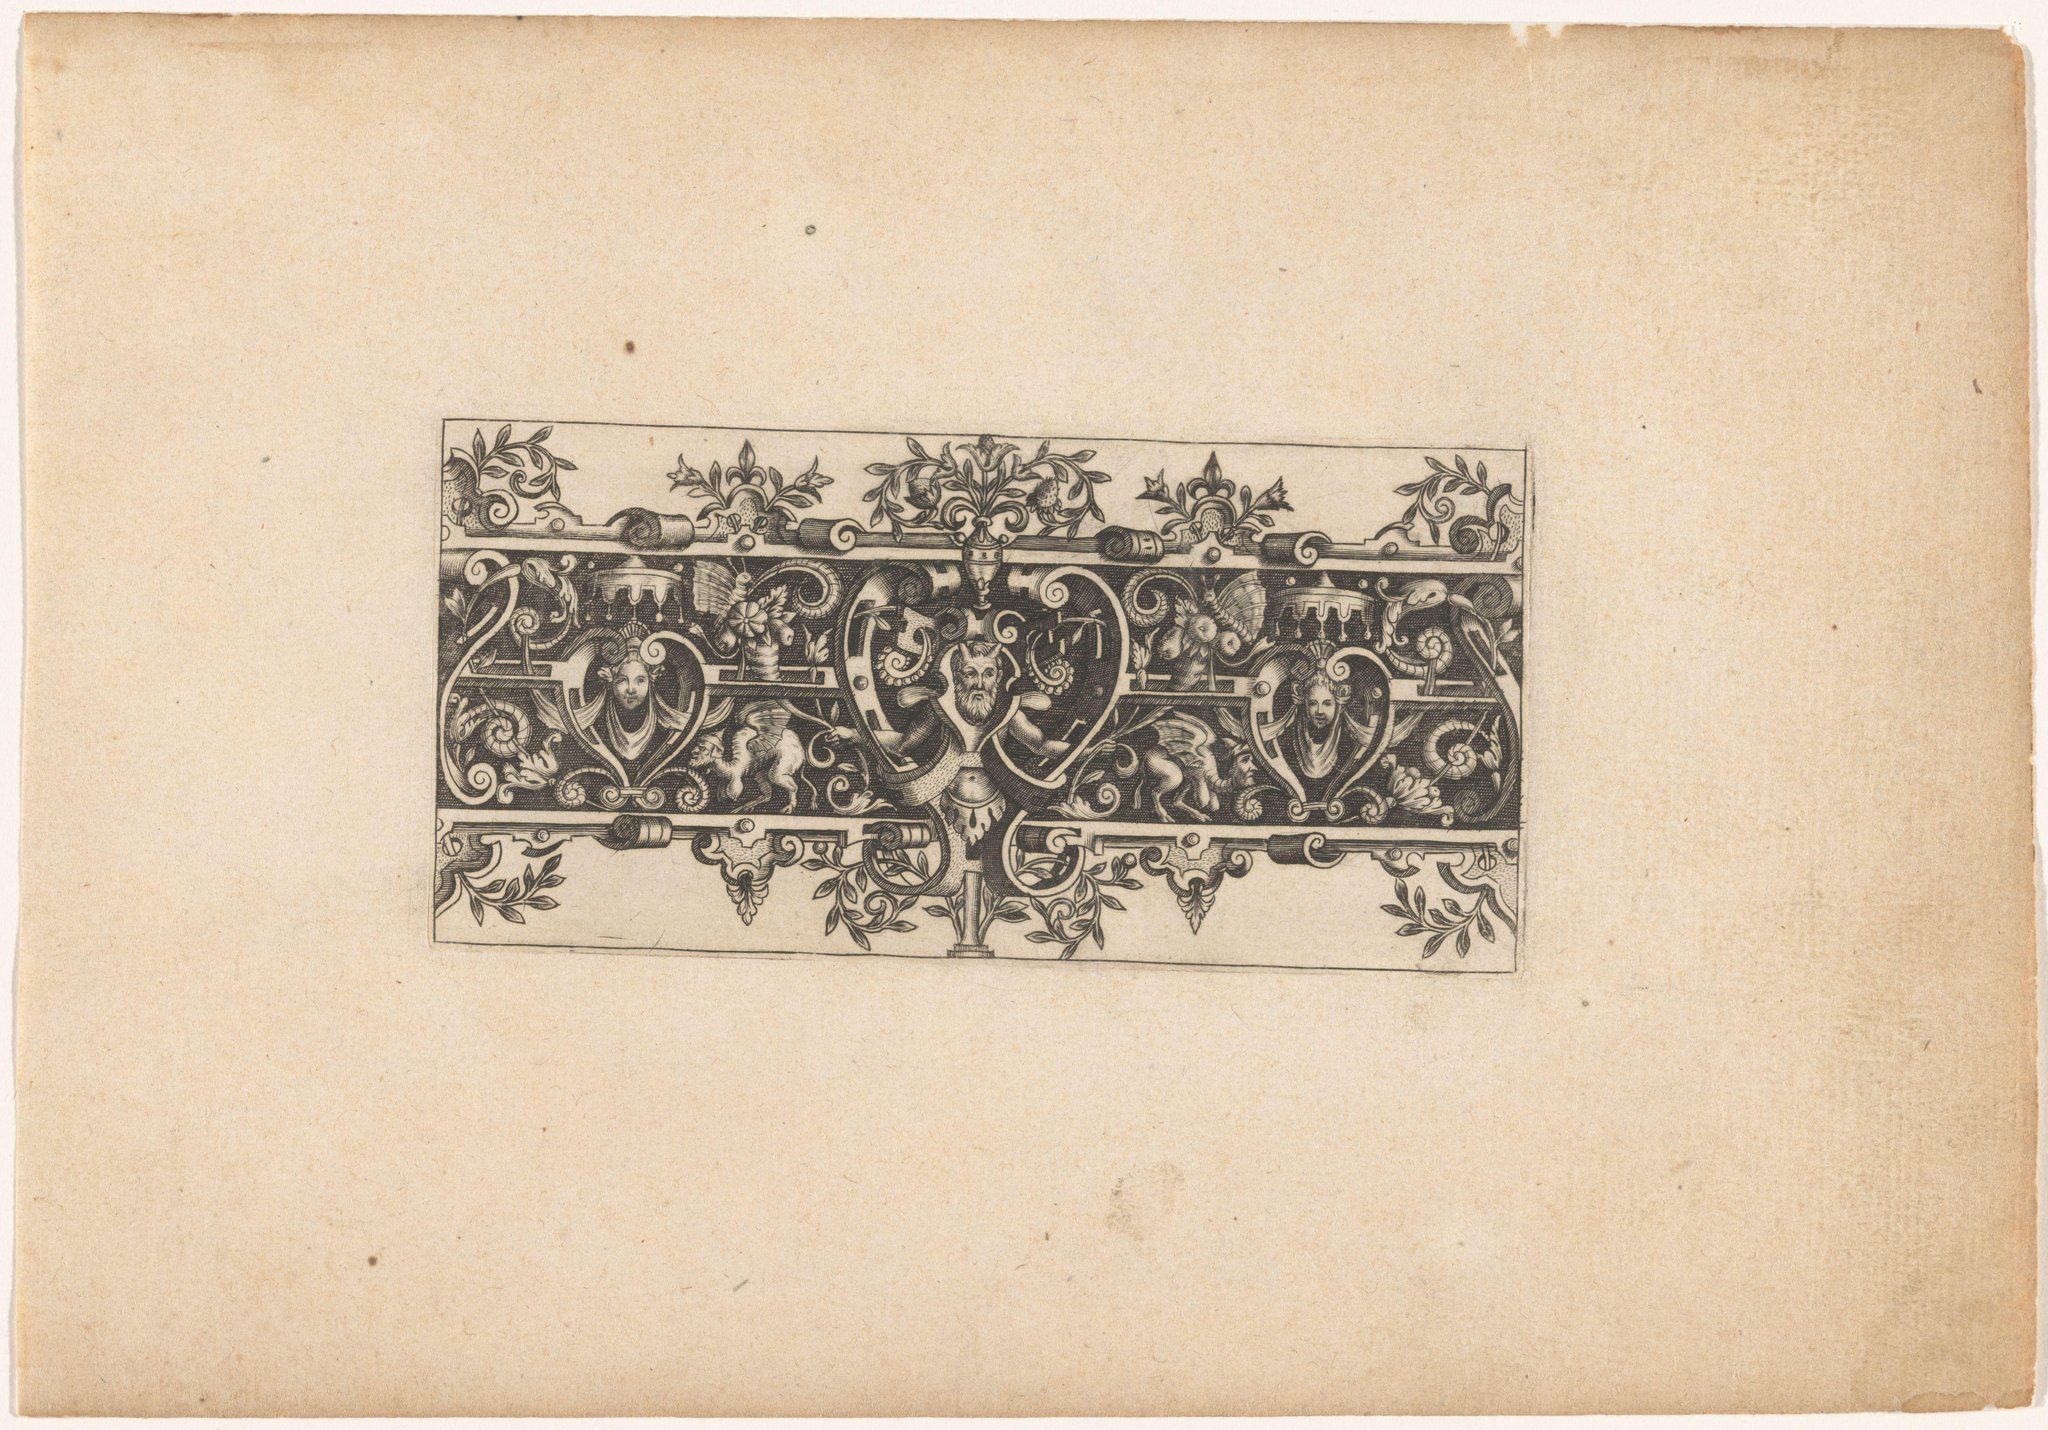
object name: print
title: Decoratie voor randen van bekers. Rolwerk met grotesken op een gearceerde achtergrond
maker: Anonymous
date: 1589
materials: paper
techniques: engraving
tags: 'cornucopia', horn of plenty, ornaments ~ art, scrollwork, strapwork ~ ornament, plants and herbs: strawberry, insects: butterfly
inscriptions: collector's mark: Lugt 2228, collector's mark: Lugt 2760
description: In het midden staat een herme gevangen in het rolwerk. In elke hand houdt hij een hoorn des overvloeds waarop aan het uiteinde een vlinder zit. M.b. staat een vaas met drie ranken die elk een aardbei dragen. Een blad uit een serie van vier.